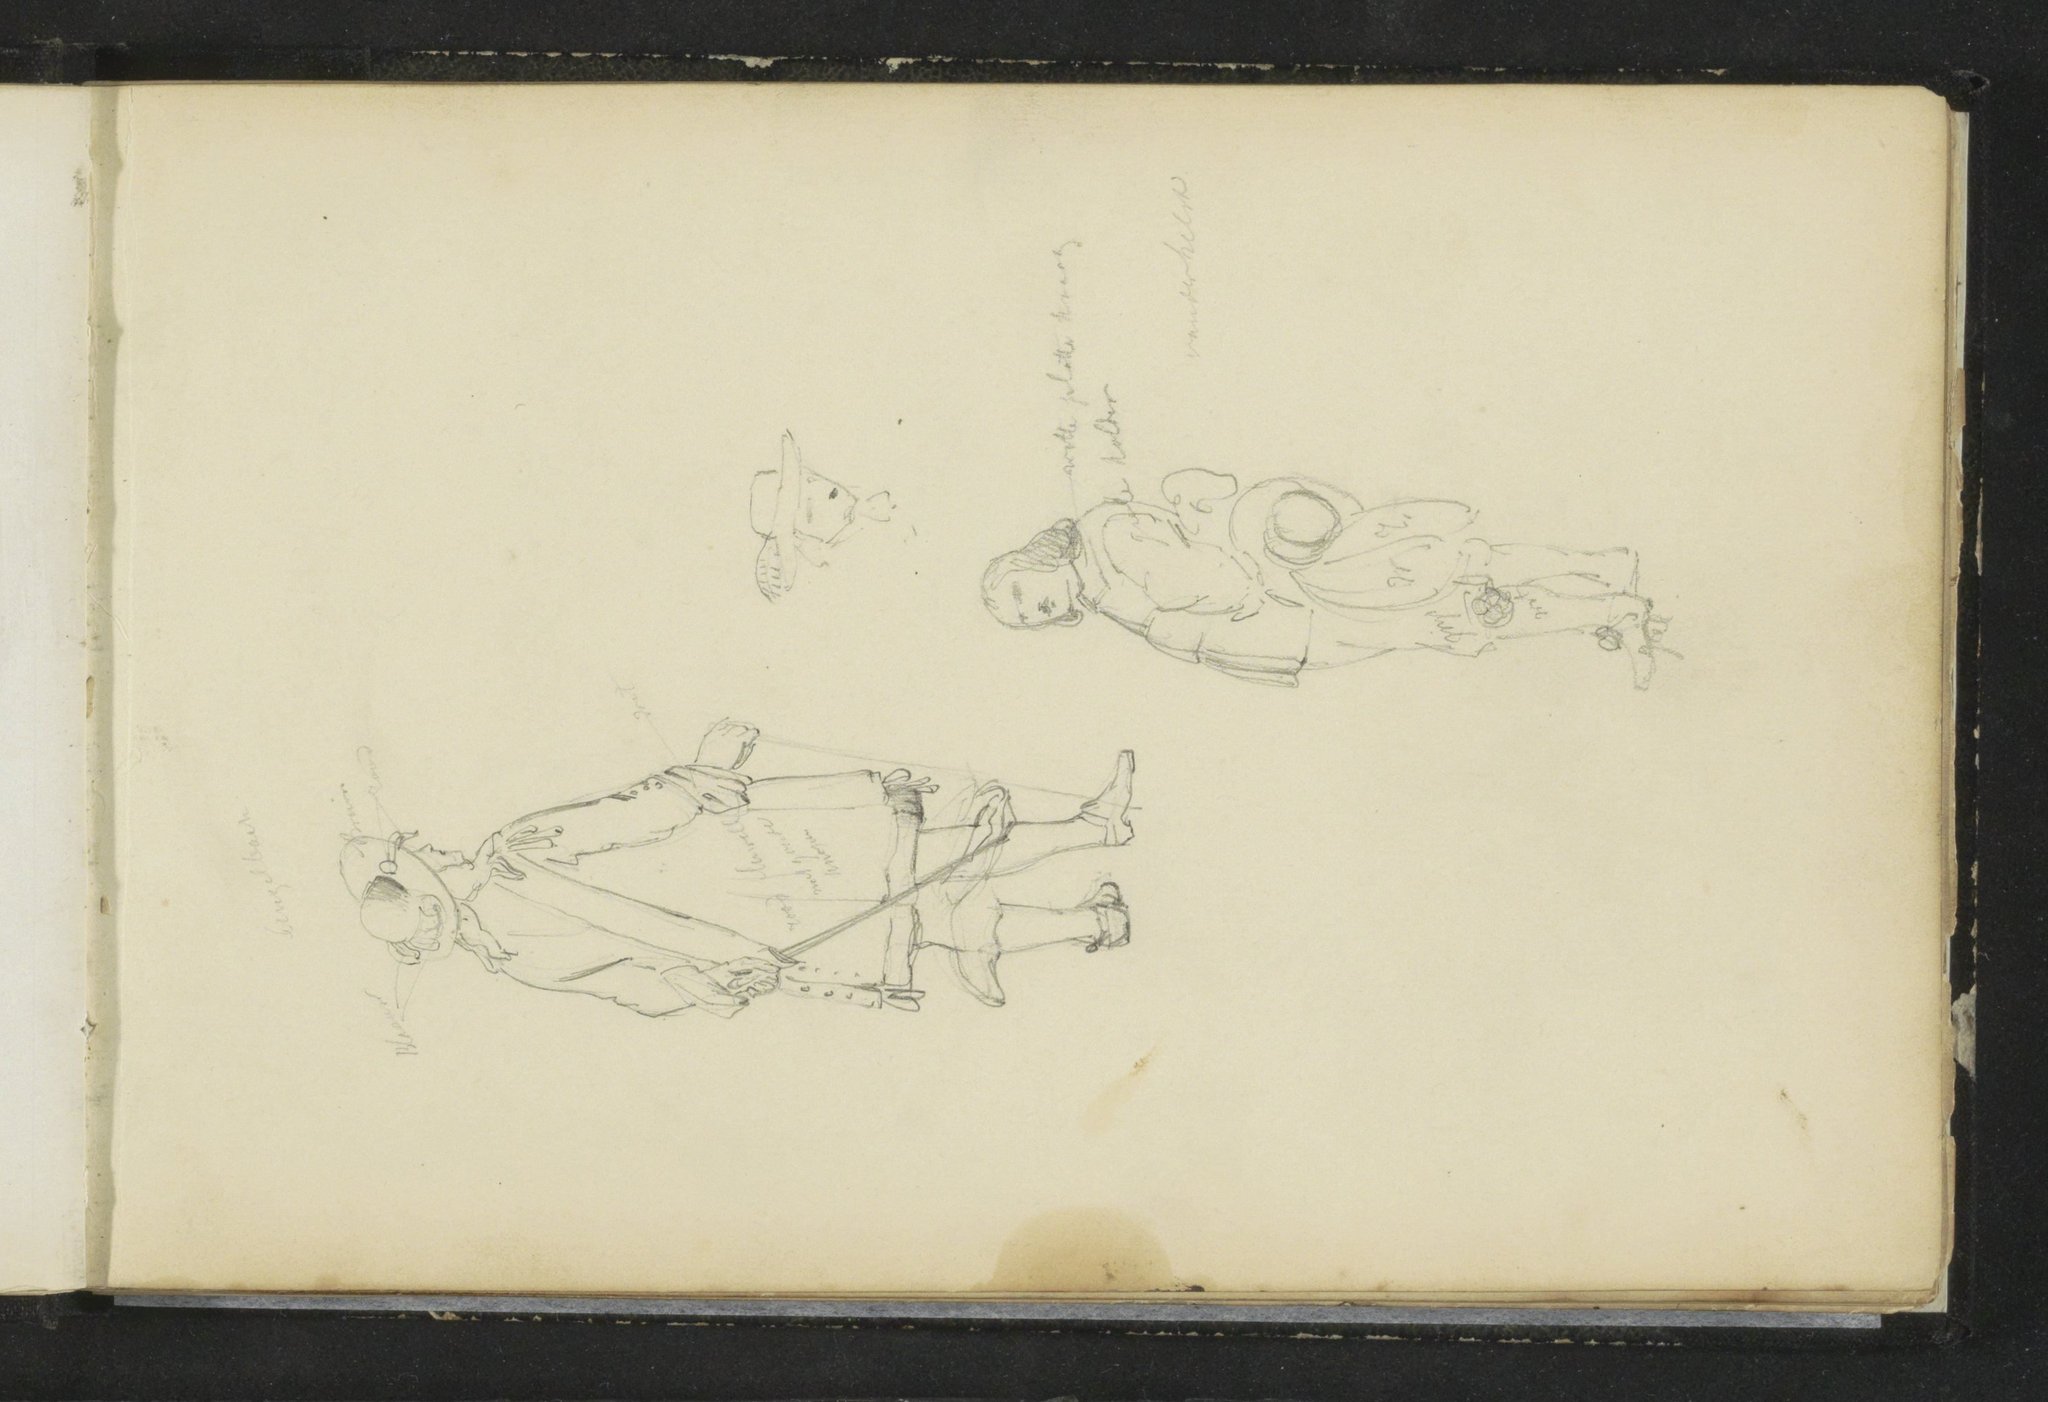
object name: sketchbook leaf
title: Mannen in zeventiende-eeuwse kleding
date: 1846-1882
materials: paper, pencil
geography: netherlands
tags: adult man, clothes, costume (+ men's clothes)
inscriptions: annotation: ‘Lingelbach’, annotation, annotation: ‘vanderhelst’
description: Mannen in zeventiende-eeuwse kleding. Blad 8 uit een schetsboek met 91 bladen.